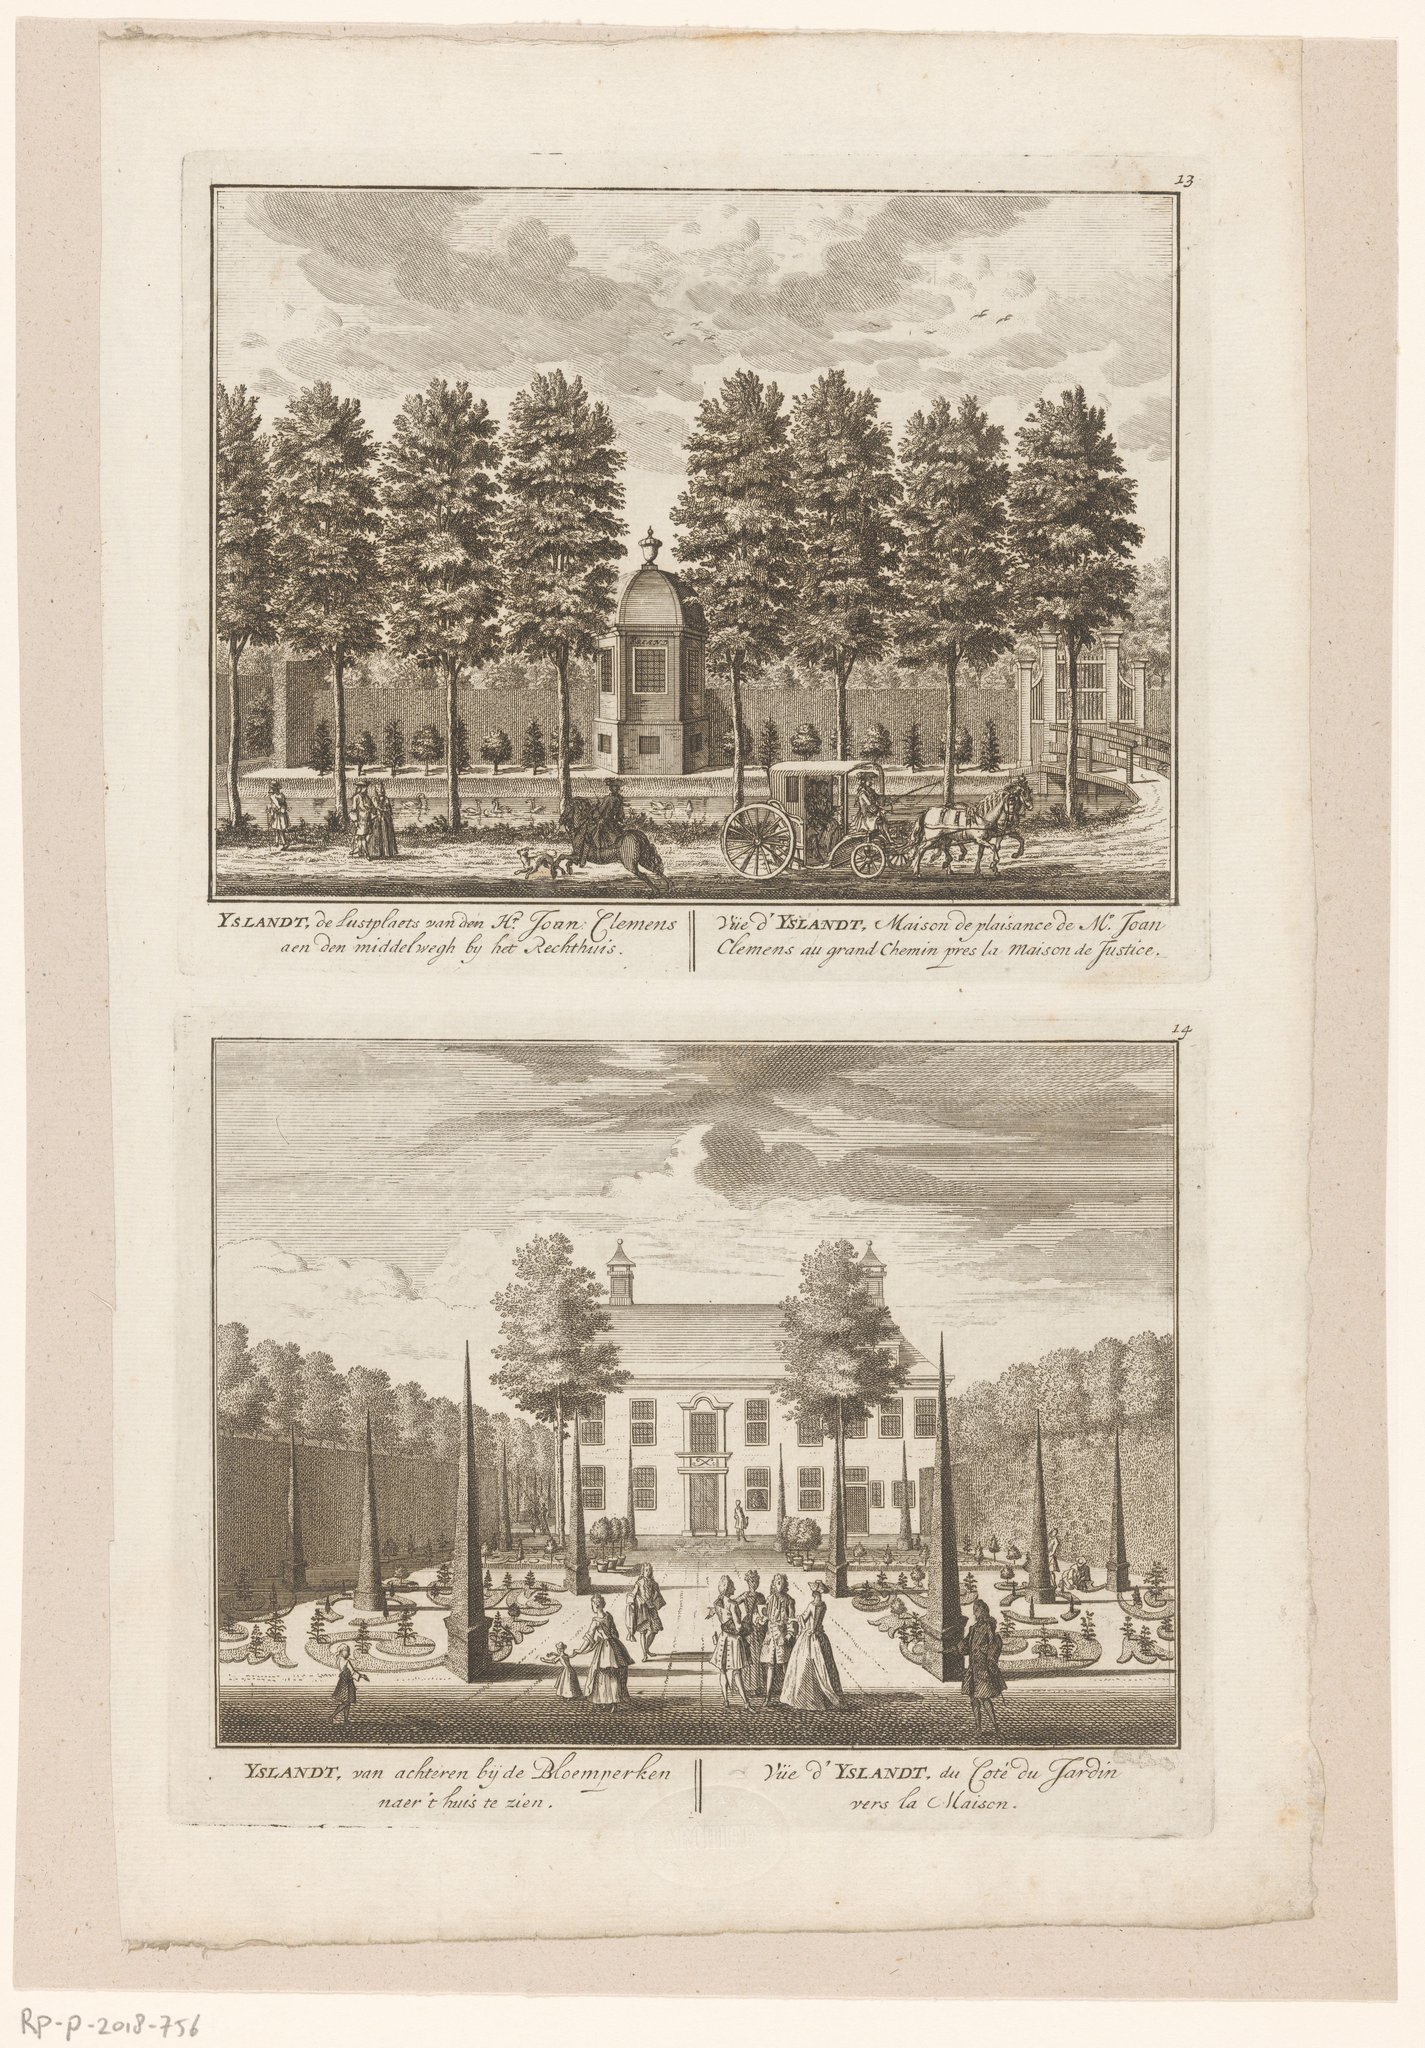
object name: print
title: Yslandt, de lustplaets van den hr. Joan Clemens aen den middelwegh (...) / Vüe d'Yslandt, maison de plaisance de mr. Joan Clemens au grand chemin (...)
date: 1725-1768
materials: paper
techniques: engraving, etching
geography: amsterdam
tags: french or architectonic garden; formal garden, lane, alley, country-house, amsterdam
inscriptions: check stamp: ‘Archief Ministerie van Oorlog Afdeeling Genie’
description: Prent gebruikt in: Niedek, Mattaeus Brouërius. Het verheerlykt Watergraafs- of Diemermeer by de stadt Amsterdam (...). Amsterdam: Andries en Hendrik de Leth, 1725. Of in: Niedek, Mattaeus Brouërius. Het verheerlykt Watergraafs- of Diemermeer by de stadt Amsterdam (...). Amsterdam: Pieter Jan Entrop, 1768.